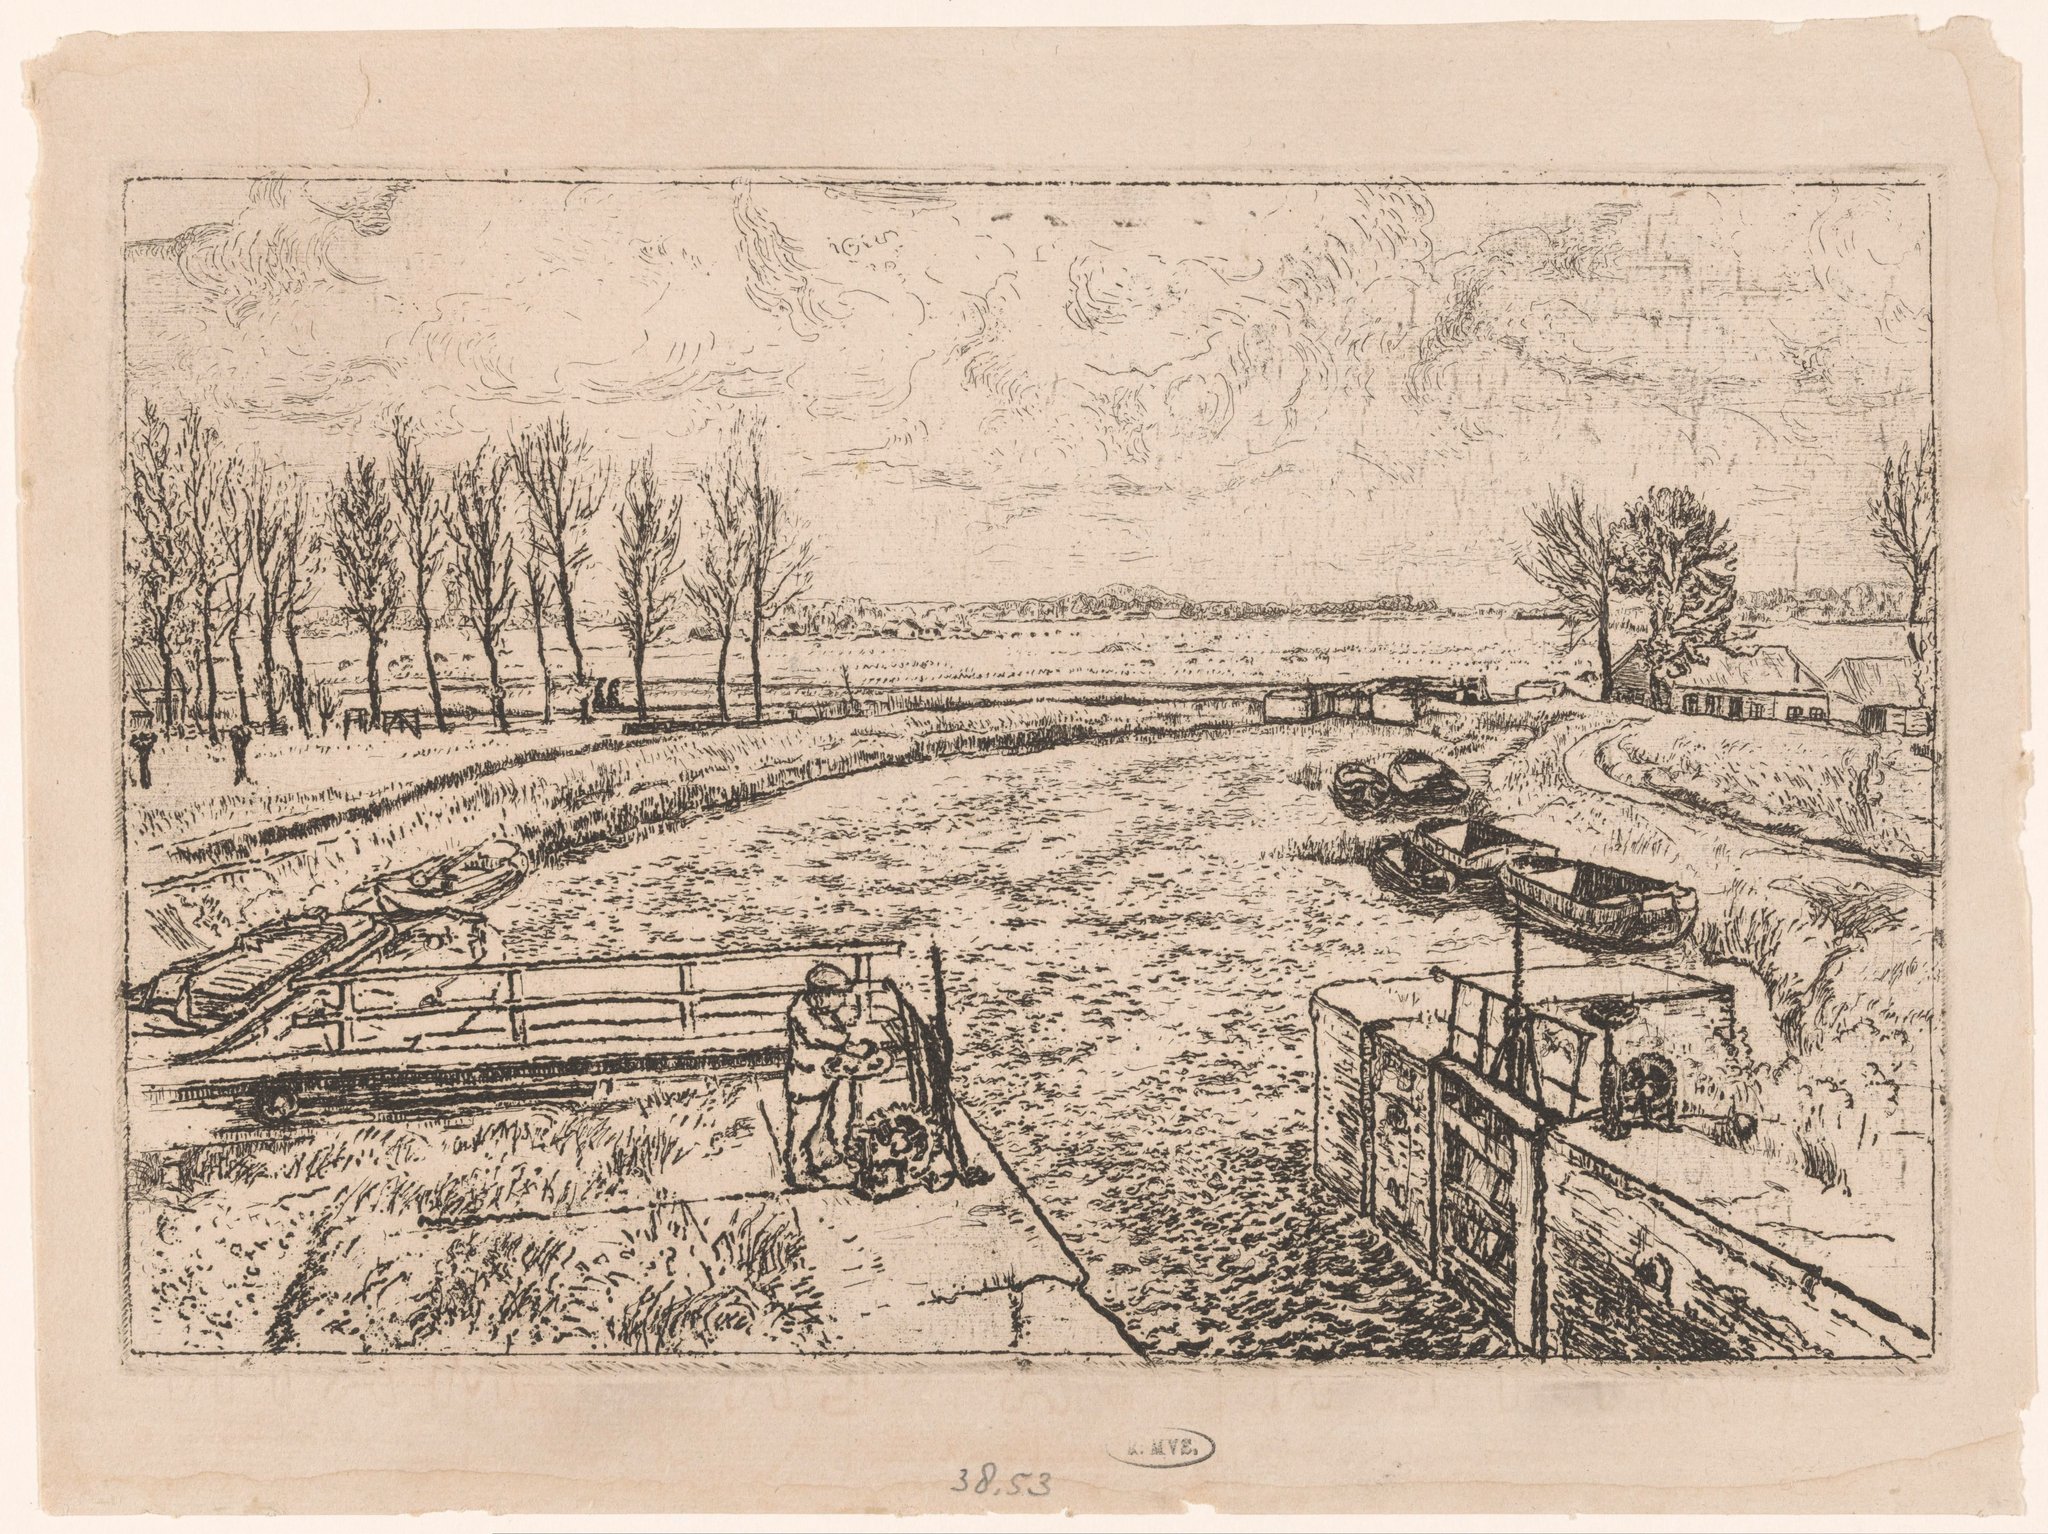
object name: print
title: Schutsluis aan de IJssel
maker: johannes proost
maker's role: print maker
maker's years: 1882-1942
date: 1892-1938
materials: paper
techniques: etching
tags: river, lift-lock, canal lock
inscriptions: collector's mark: Lugt 2228